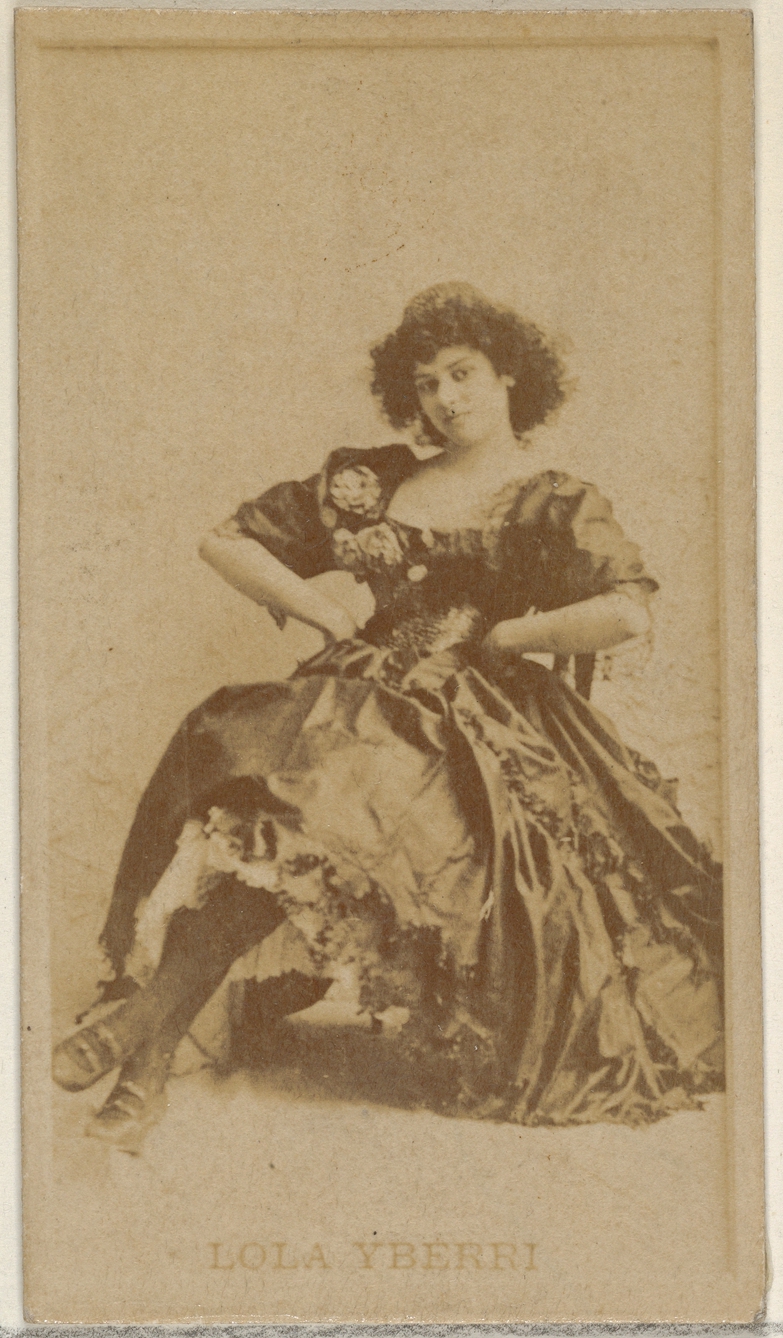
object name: photograph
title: Lola Yberri, from the Actors and Actresses series (N45, Type 8) for Virginia Brights Cigarettes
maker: allen & ginter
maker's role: publisher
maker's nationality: american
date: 1888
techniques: albumen silver print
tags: portraits,women,actresses